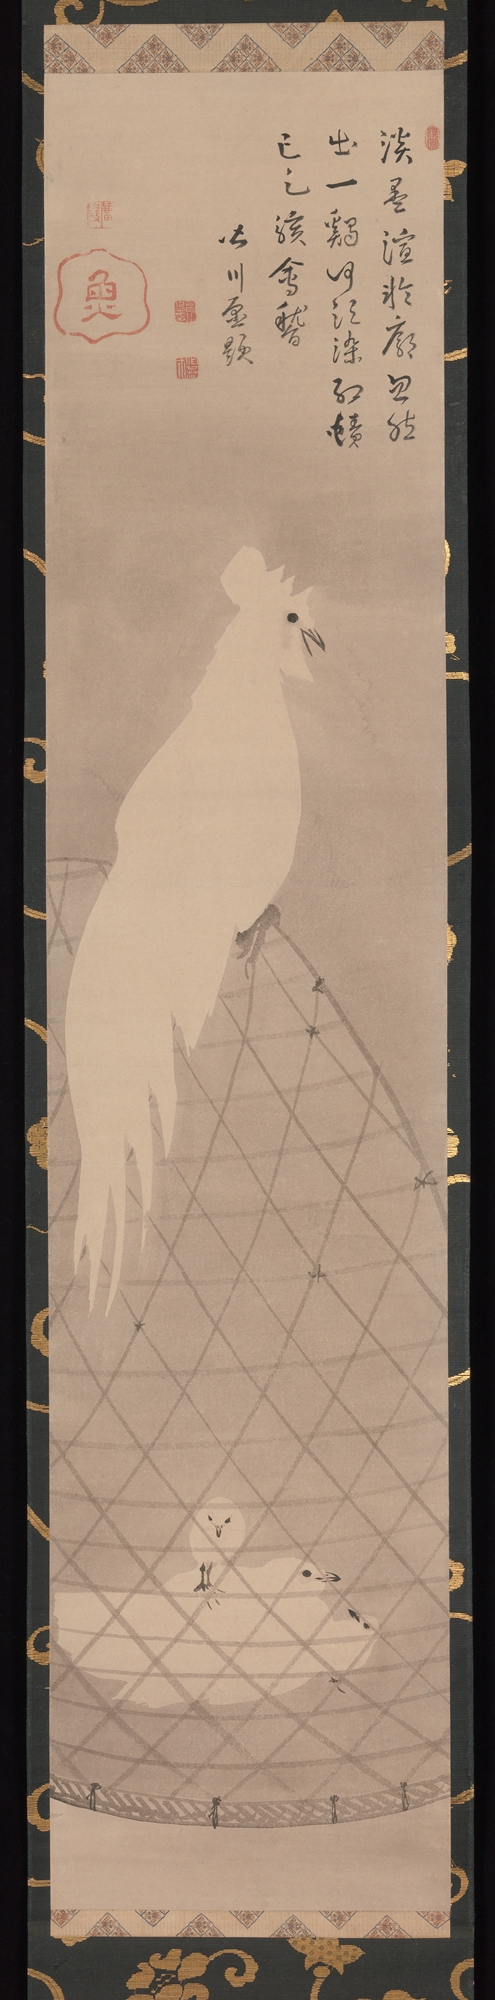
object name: hanging scroll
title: Rooster, Hen, and Chicks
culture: japanese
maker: nagasawa rosetsu 長澤蘆雪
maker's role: artist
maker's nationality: japanese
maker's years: 1754-1799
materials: ink, paper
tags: chickens,roosters